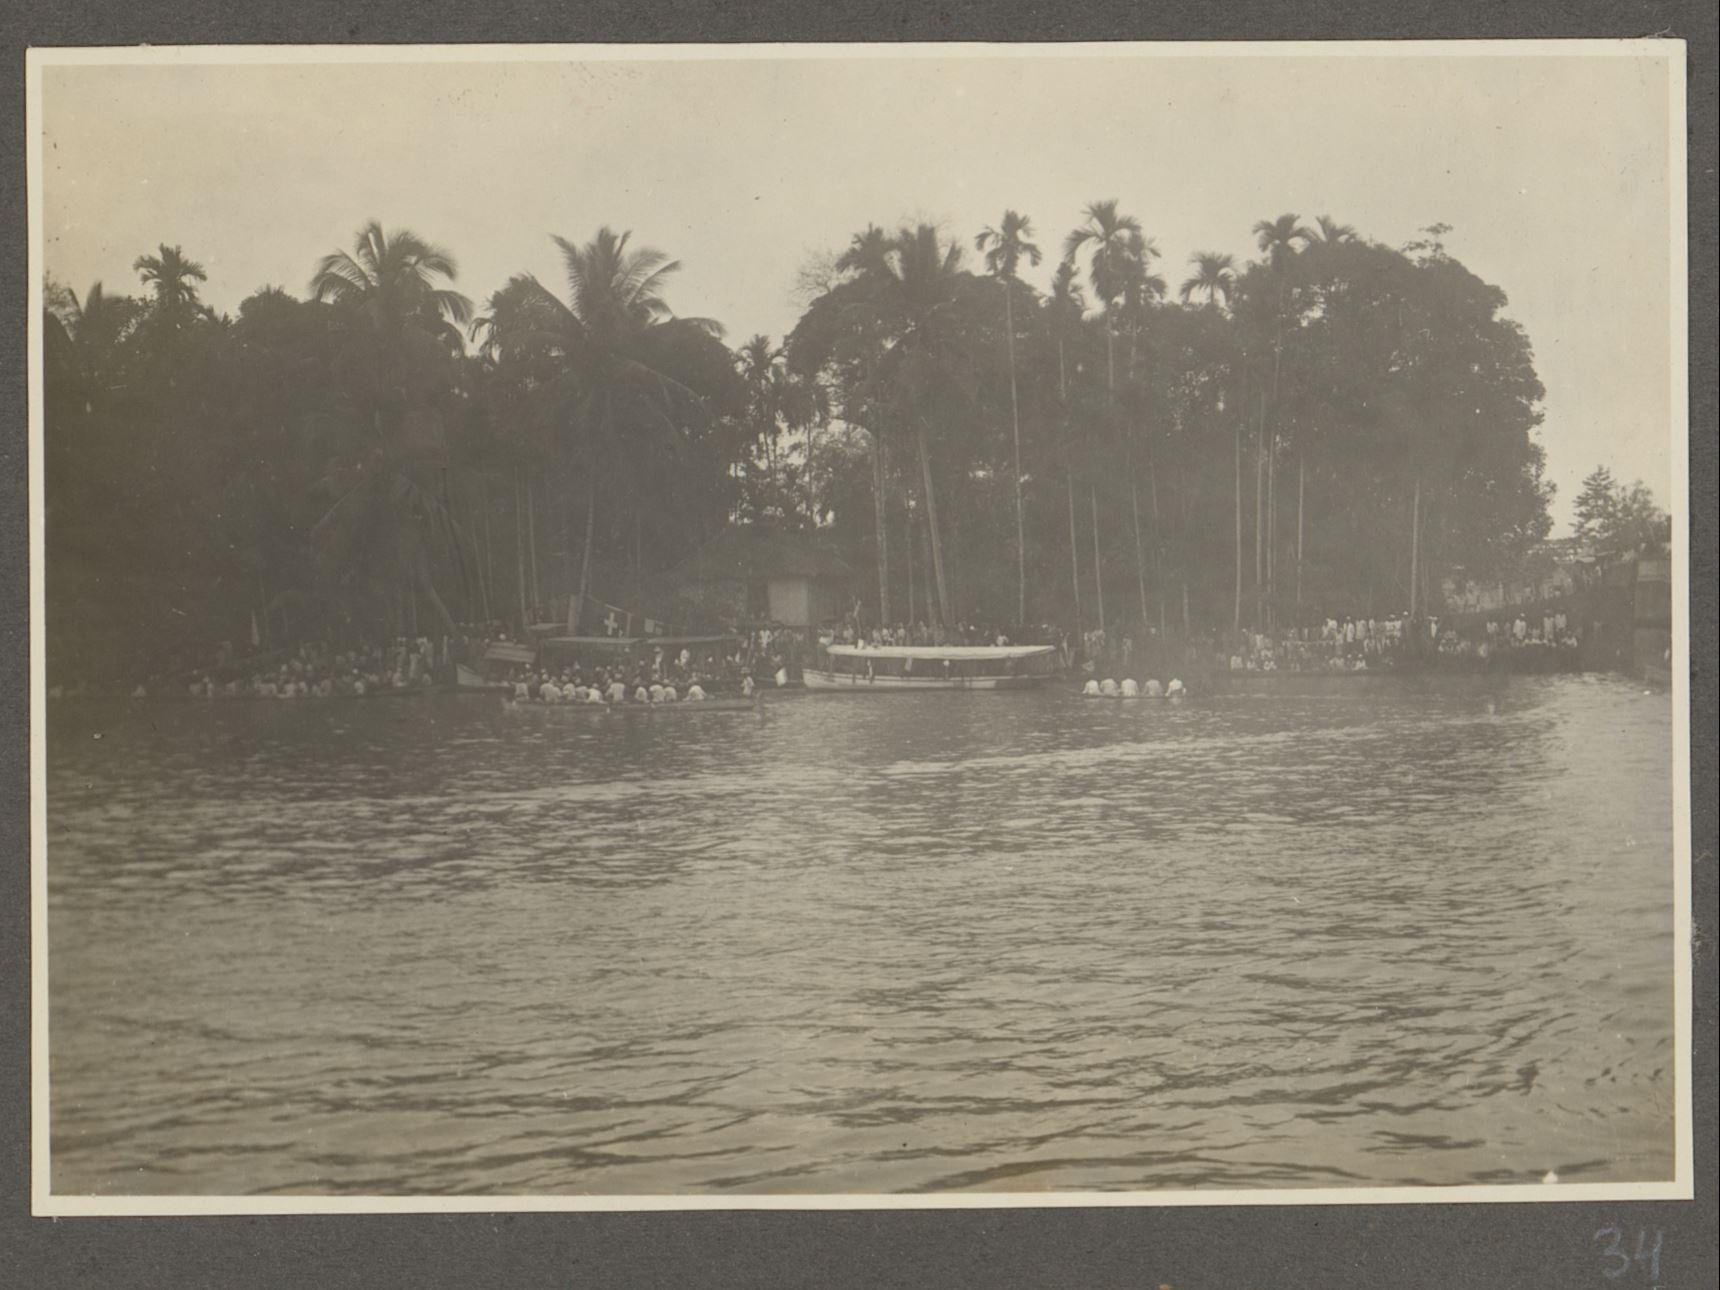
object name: album leaf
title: Roeiwedstrijden bij het jubileum van de Sultan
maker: Anonymous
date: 1919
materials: photographic support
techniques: gelatin silver print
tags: river, historical persons, rowing, canoeing, etc. (sport)